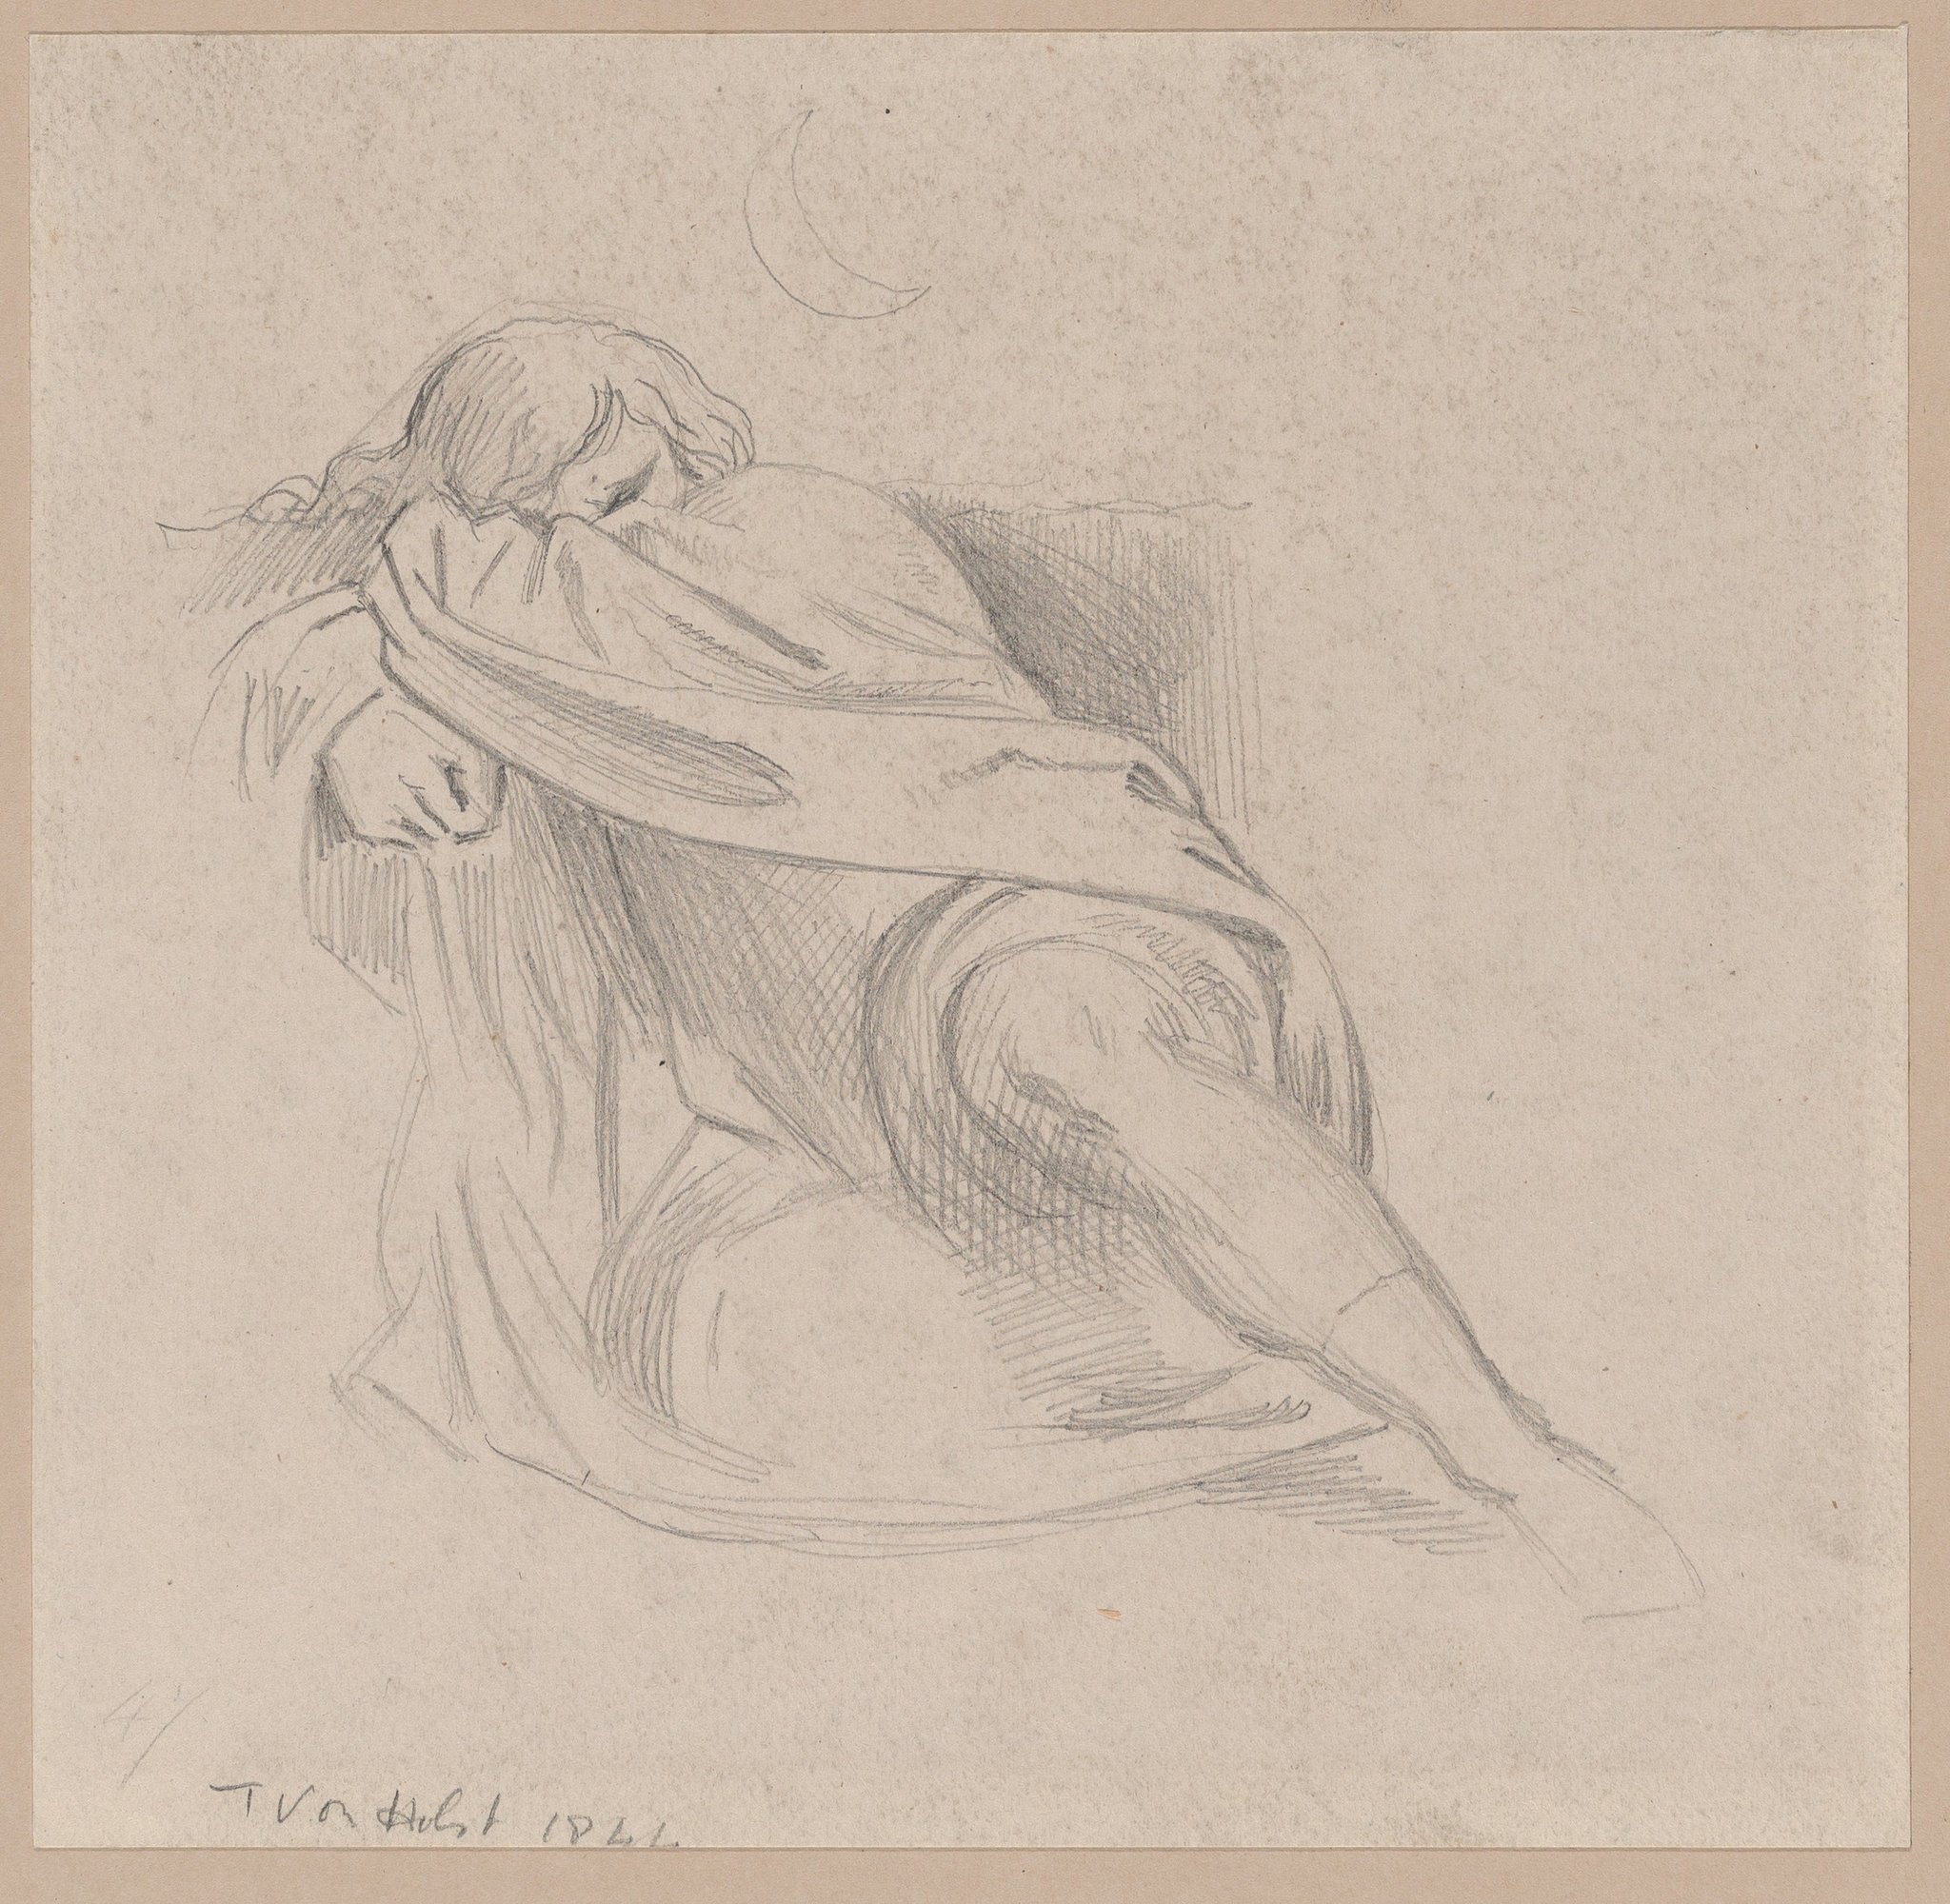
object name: drawing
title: Sleeping man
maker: theodor richard edward von holst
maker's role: artist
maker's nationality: british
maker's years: 1810-1844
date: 1844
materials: graphite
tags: sleeping,men